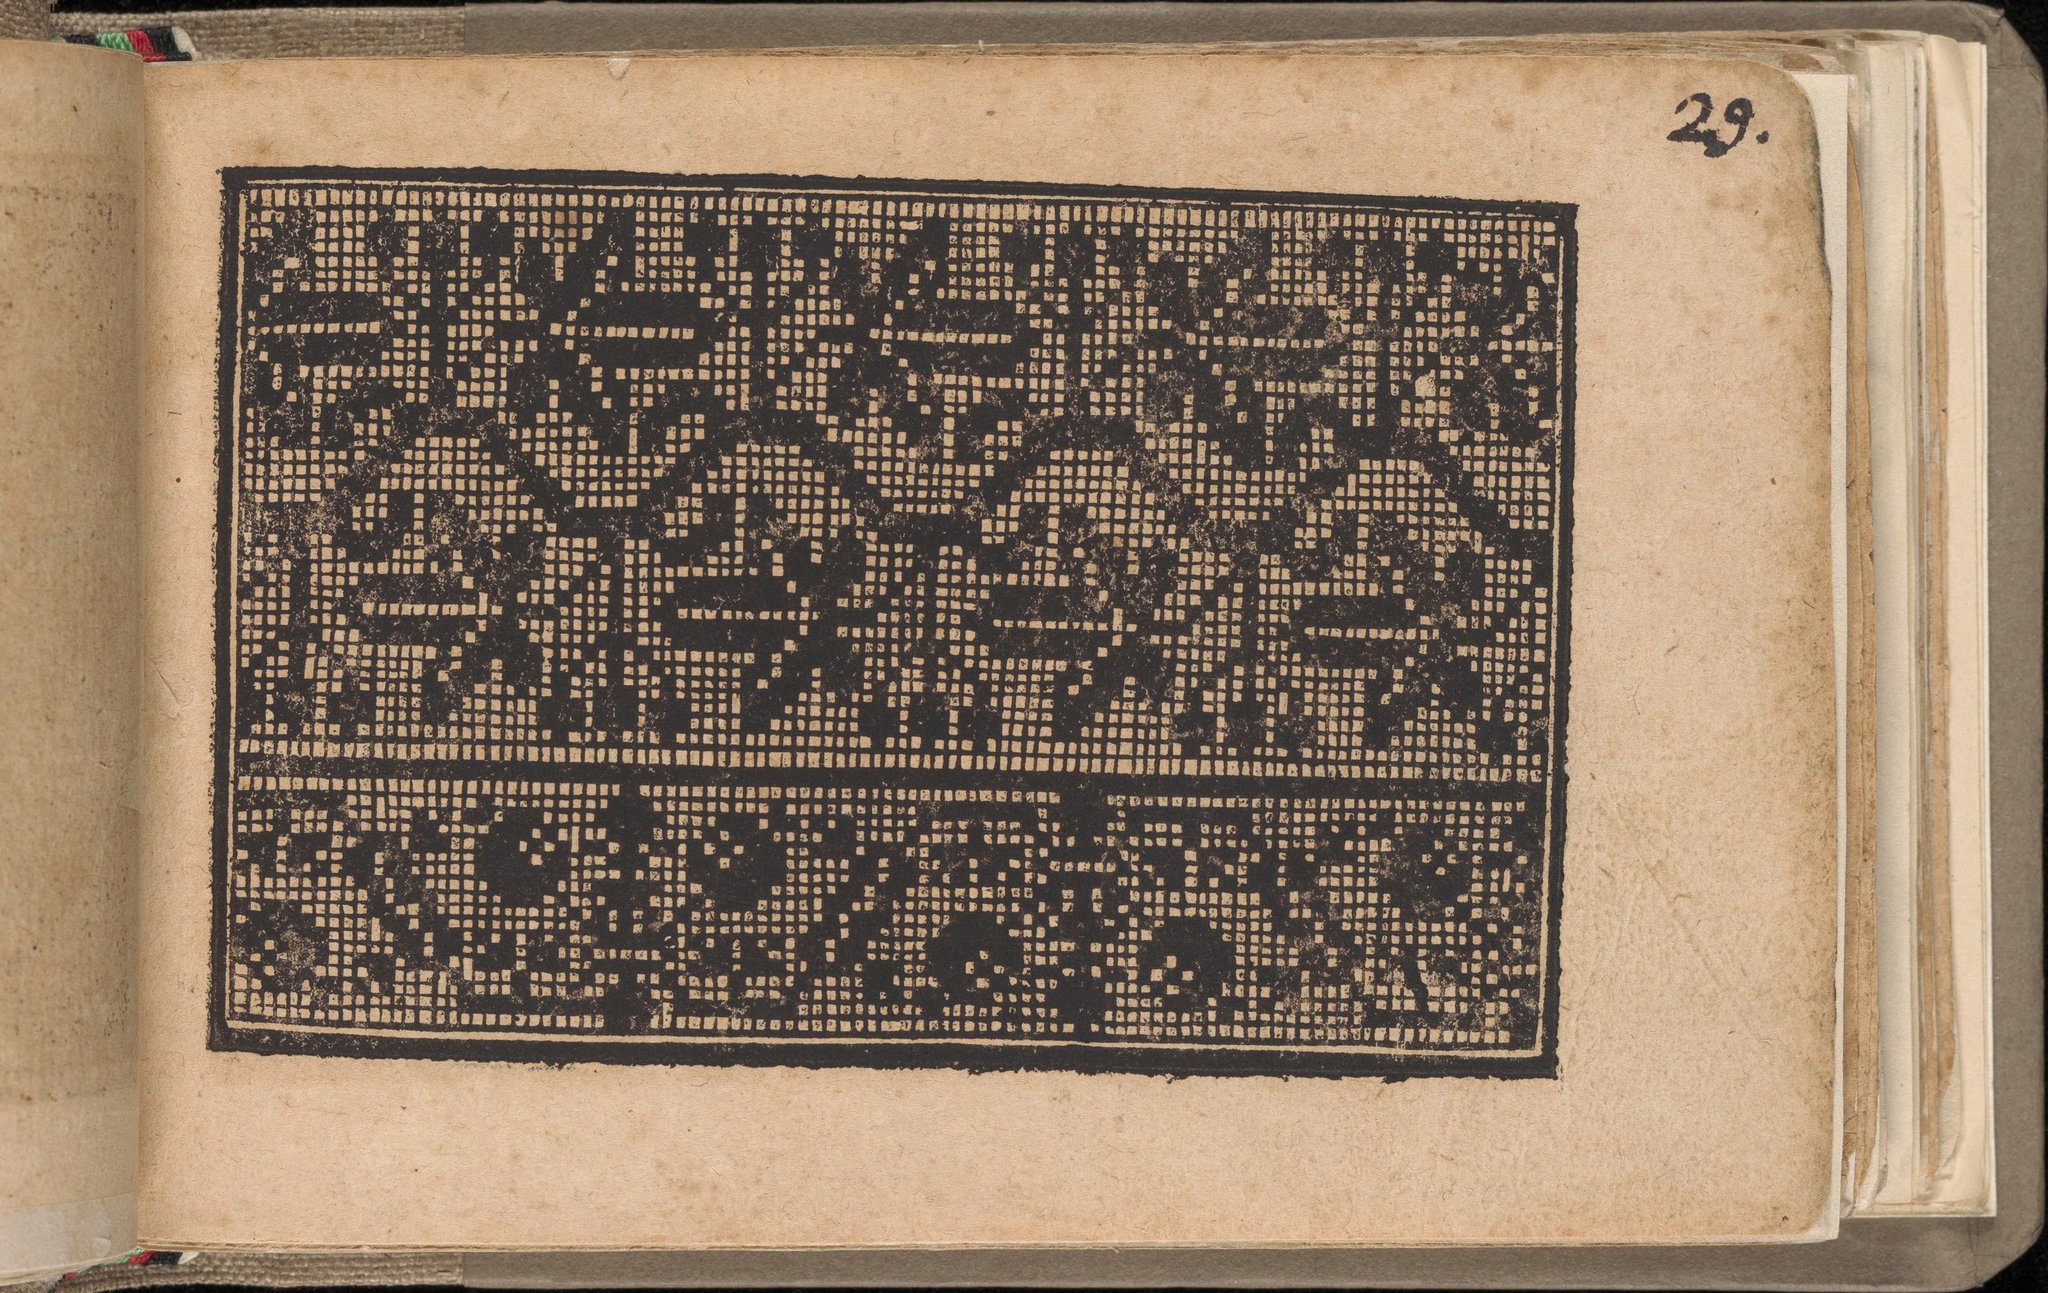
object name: book print ornament architecture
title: Schön newes Modelbuch (Page 29r)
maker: sigismundus latomus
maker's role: publisher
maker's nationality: german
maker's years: 1599-1632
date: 1608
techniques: woodcut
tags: flowers